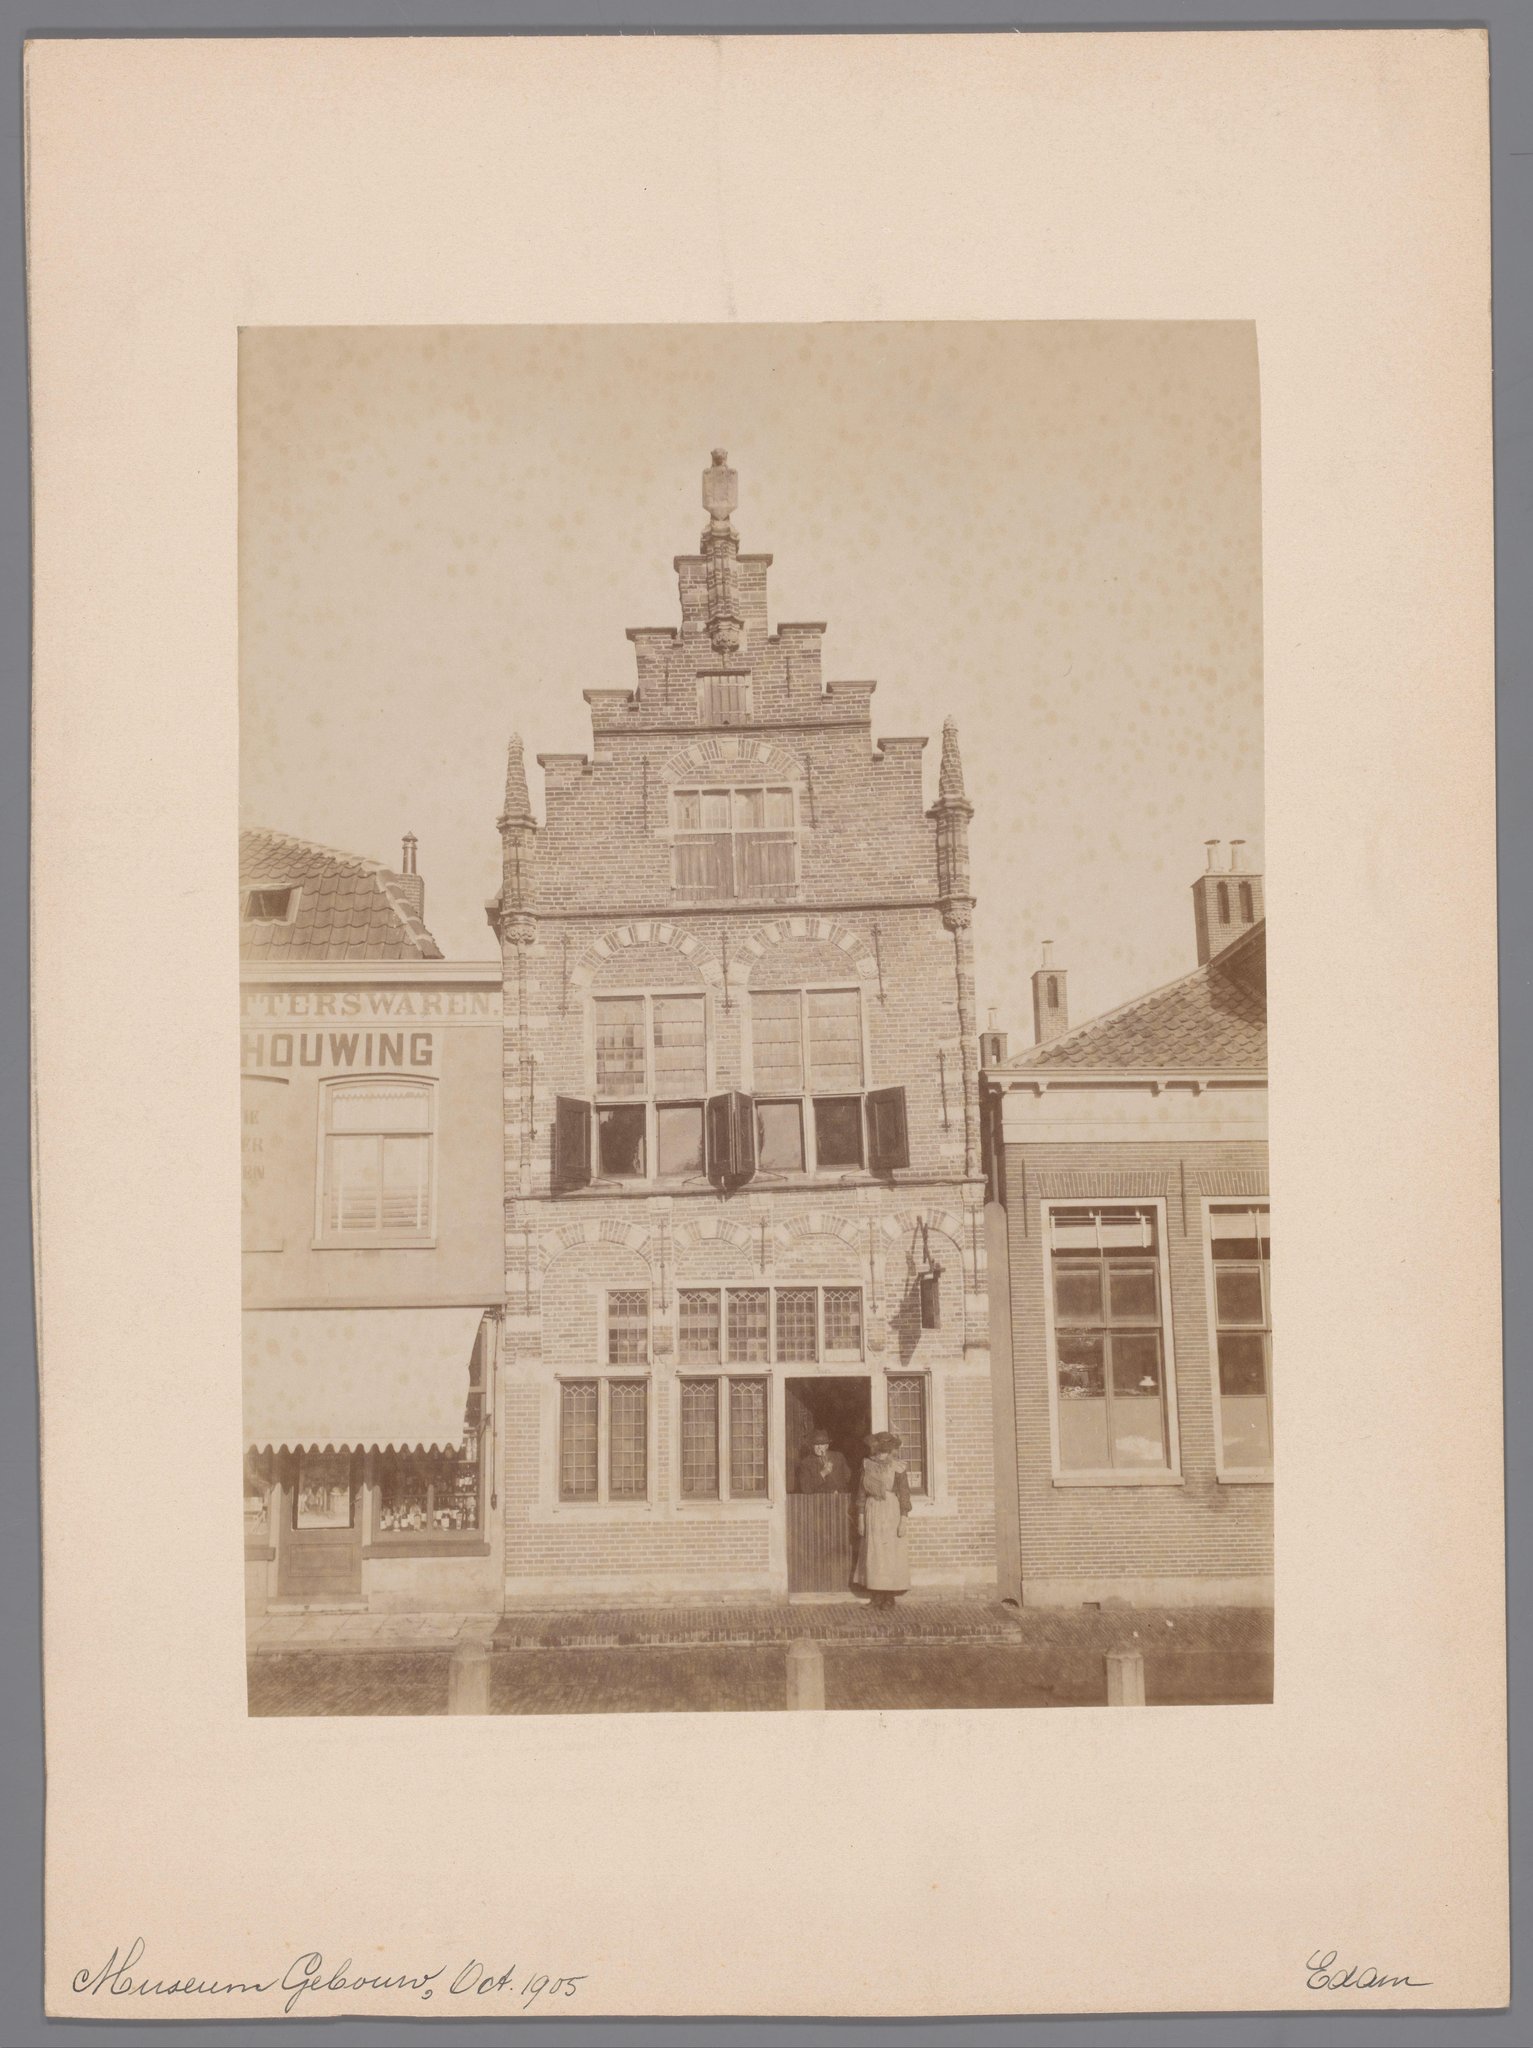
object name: photograph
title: Façade van het Edams Museum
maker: anoniem (monumentenzorg)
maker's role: fotograaf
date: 1905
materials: cardboard, photographic support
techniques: albumen print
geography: damplein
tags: permanent exhibition, museum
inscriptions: annotation: ‘Edam (N.H.)/ Museumgebouw/ oct 1905’, annotation: ‘Museum Gebouw, Oct. 1905/ Edam’